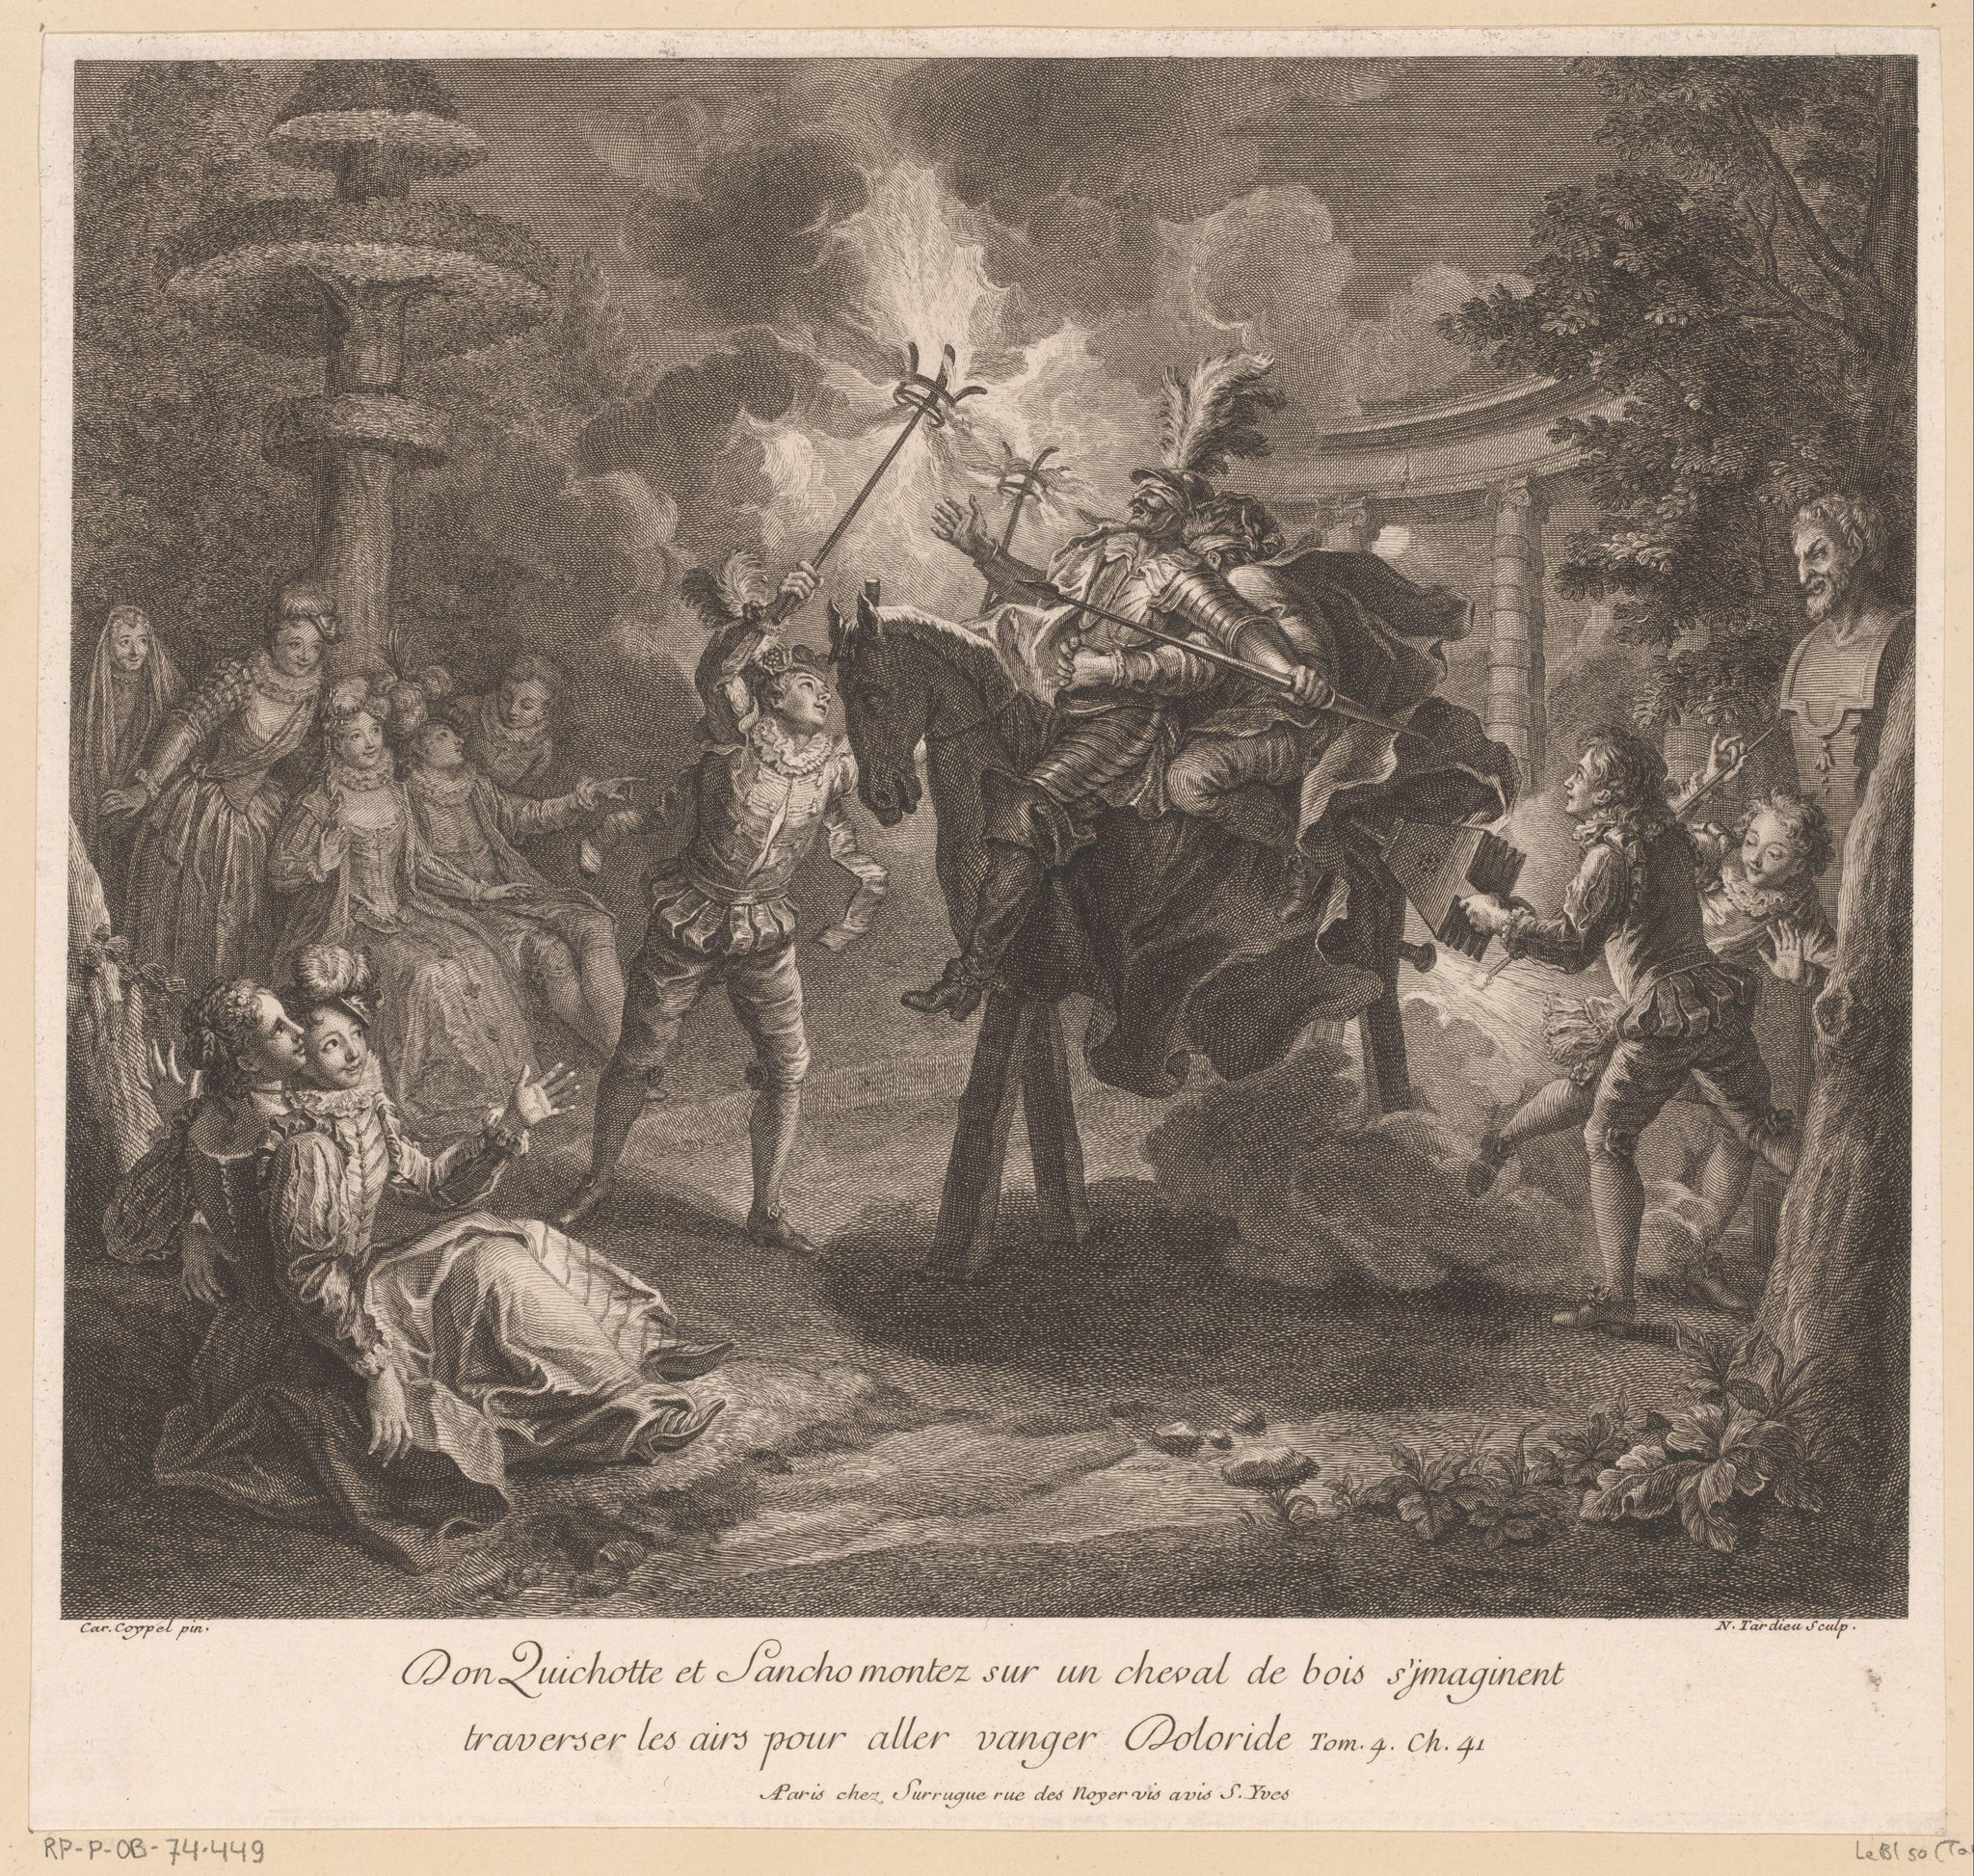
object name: print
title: Don Quichot en Sancho op een houten paard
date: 1724-1749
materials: paper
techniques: engraving, etching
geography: paris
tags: don quixote, sancho panza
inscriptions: collector's mark: Lugt 240